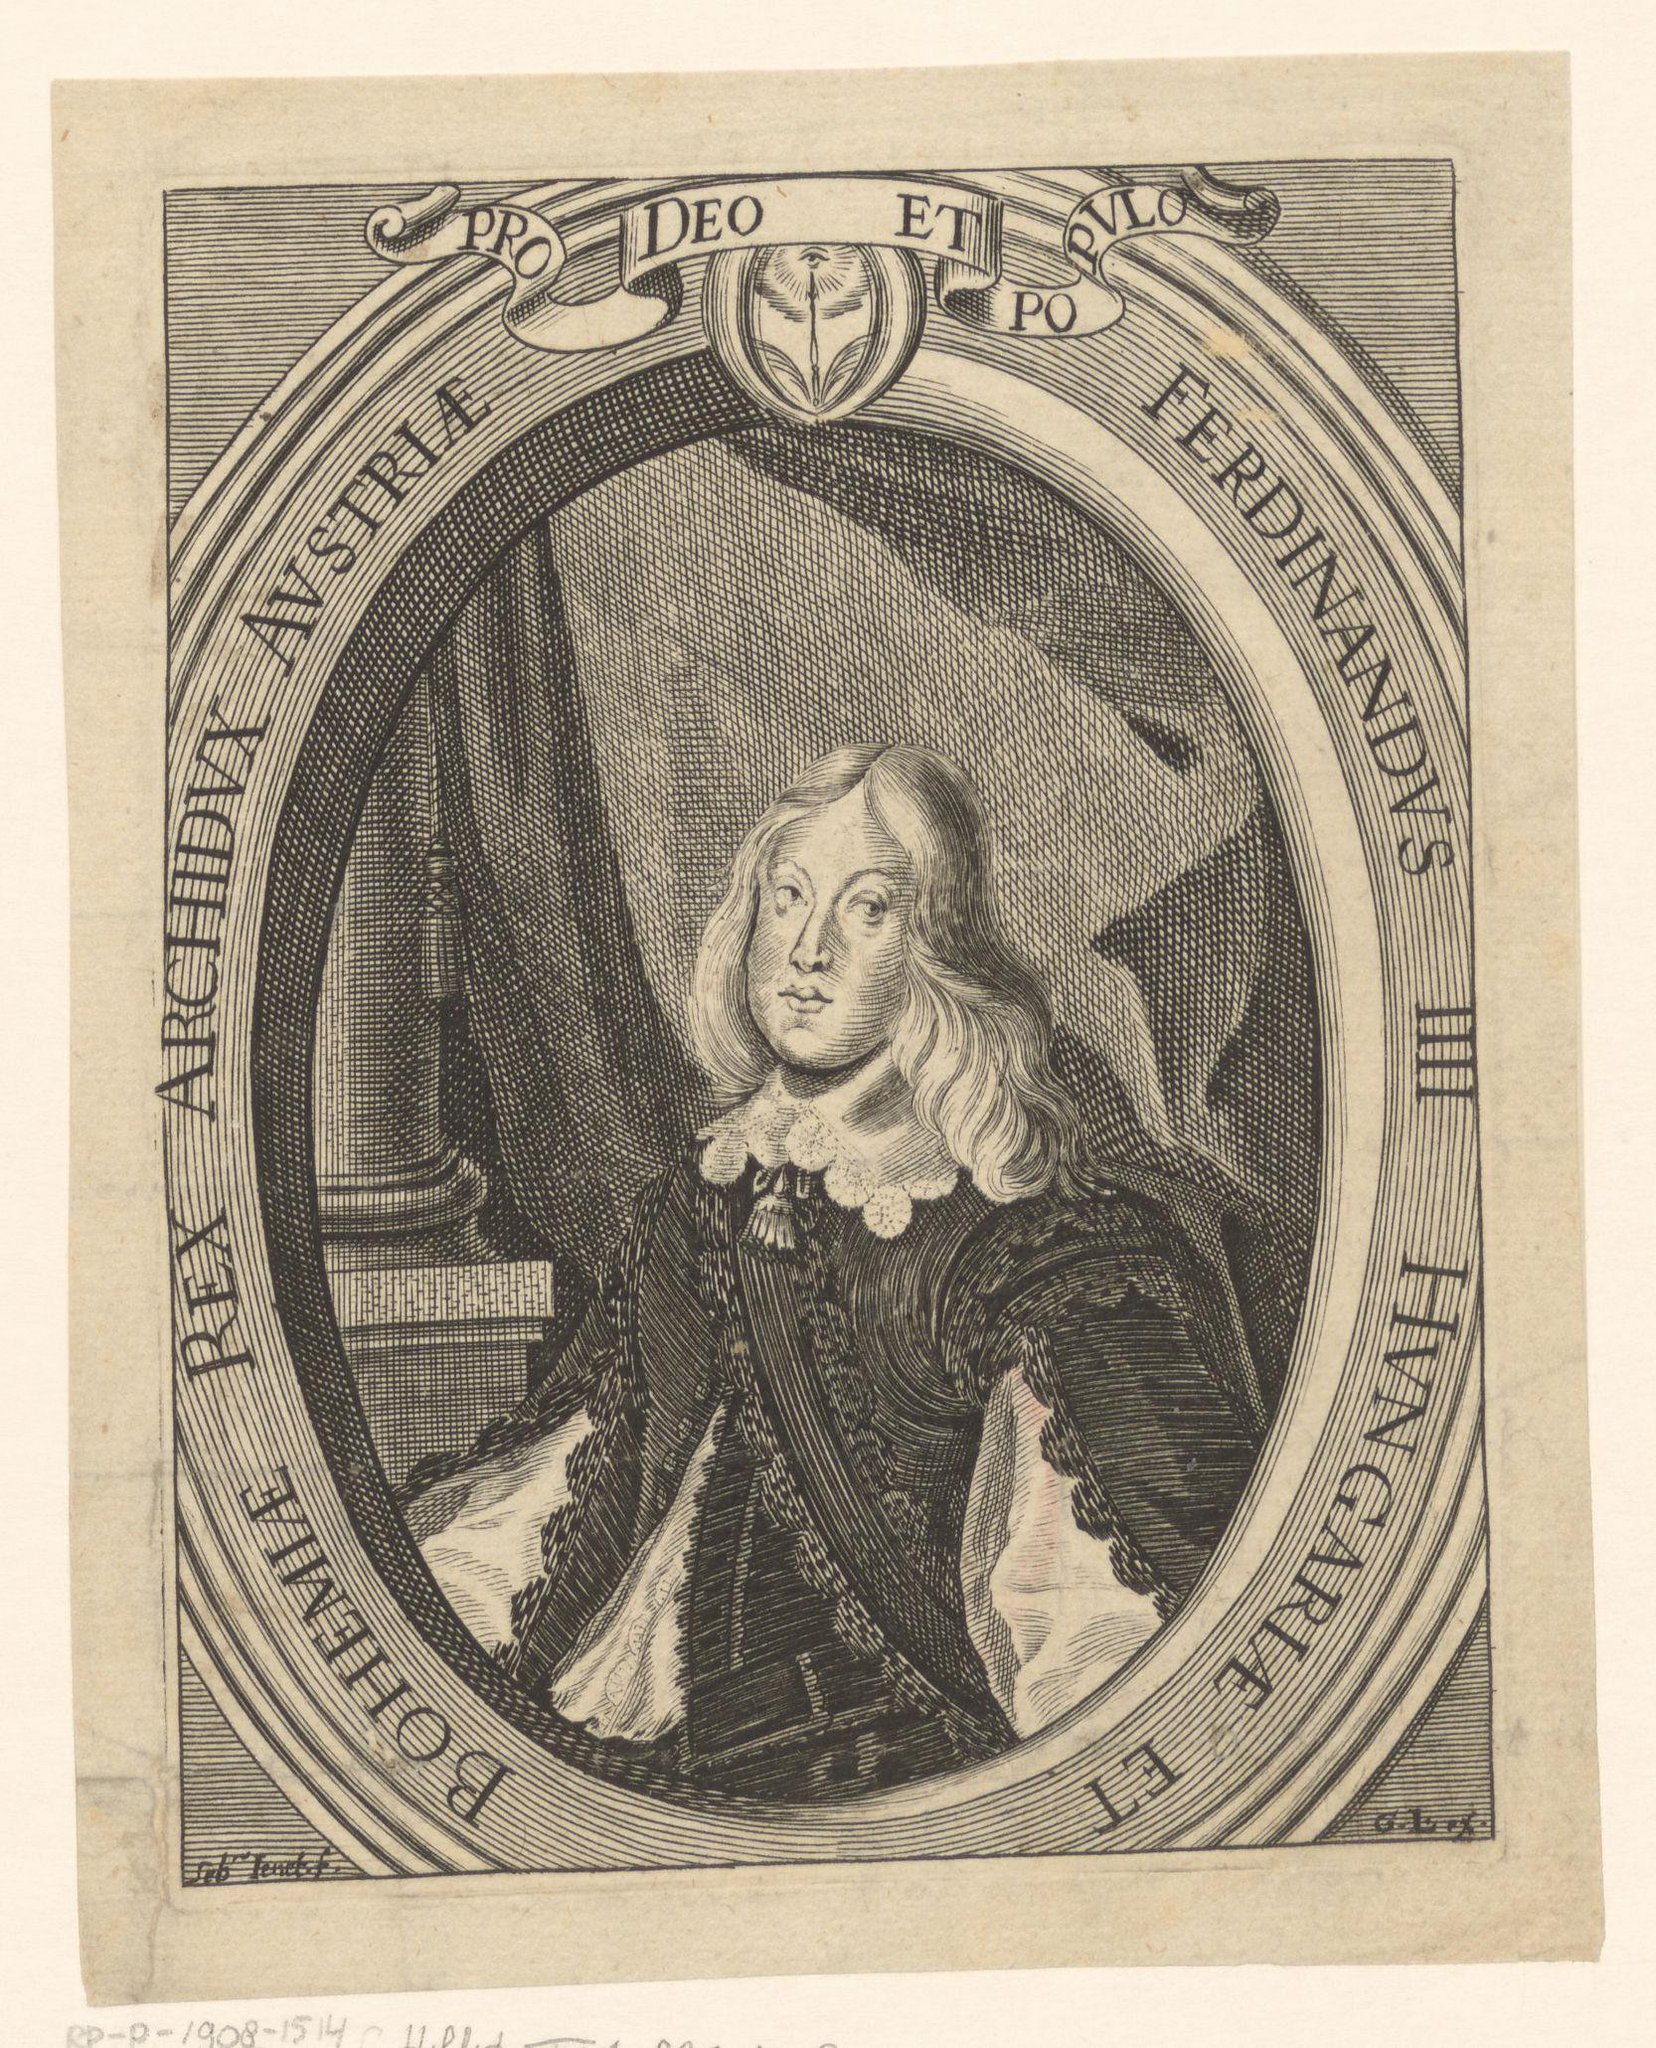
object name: print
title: Portret van Ferdinand IV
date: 1640-1660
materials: paper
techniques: engraving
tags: historical persons, pope, king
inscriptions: collector's mark: Lugt 2228